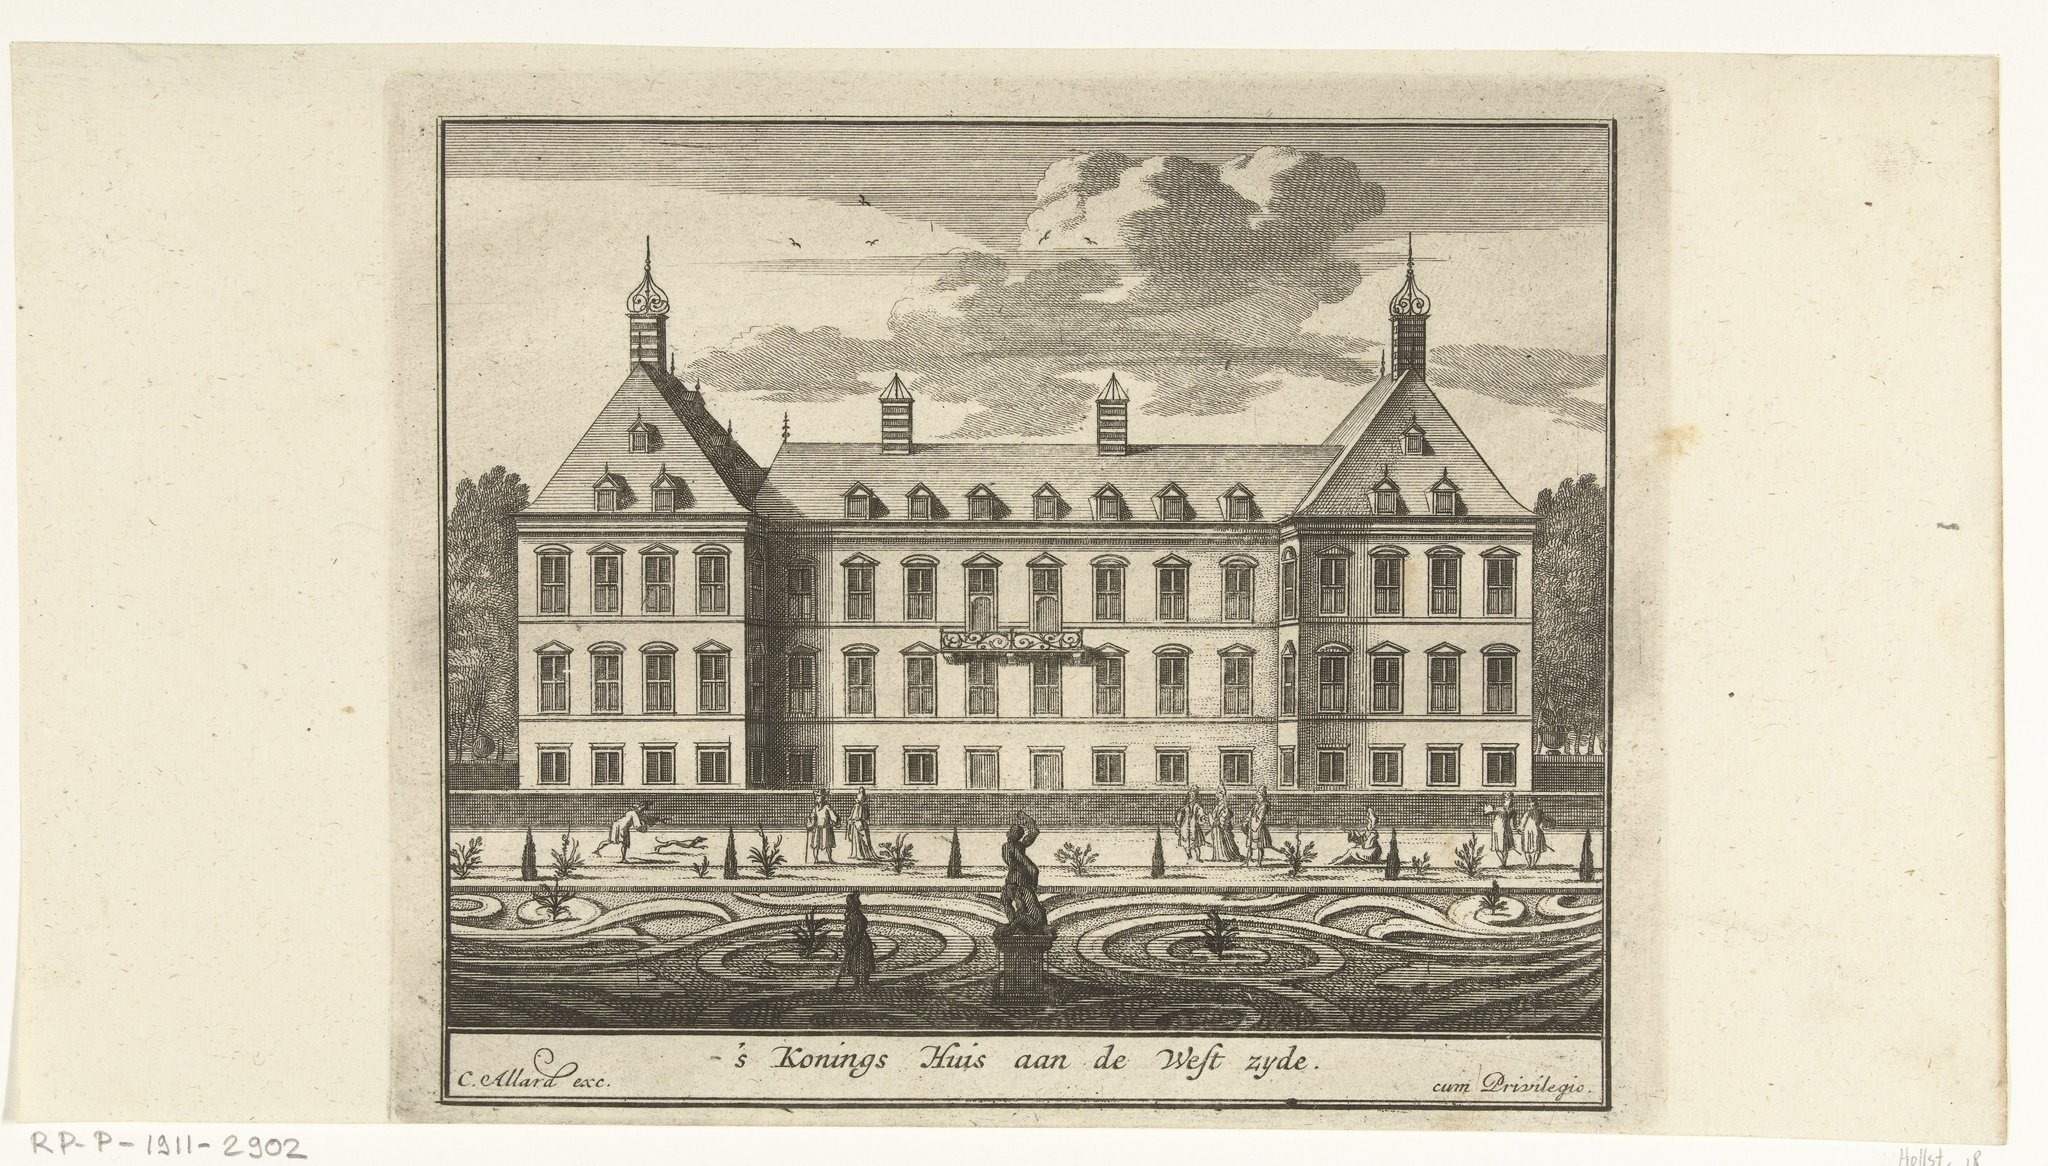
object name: print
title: Hollands Lustpark besluitende zyn Britannische majesteits hof-gebouw tot Honslaardyk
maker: carel allard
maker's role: print maker, publisher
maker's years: 1648-1709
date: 1689-1702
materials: paper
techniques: etching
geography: amsterdam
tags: garden, palace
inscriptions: collector's mark: Lugt 2228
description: Gezicht op paleis Honselaarsdijk van de westzijde, voor het paleis ligt een barokke tuin en een laan met wandelaars. Prent uit een serie van zeventien prenten van Paleis Honselaarsdijk.